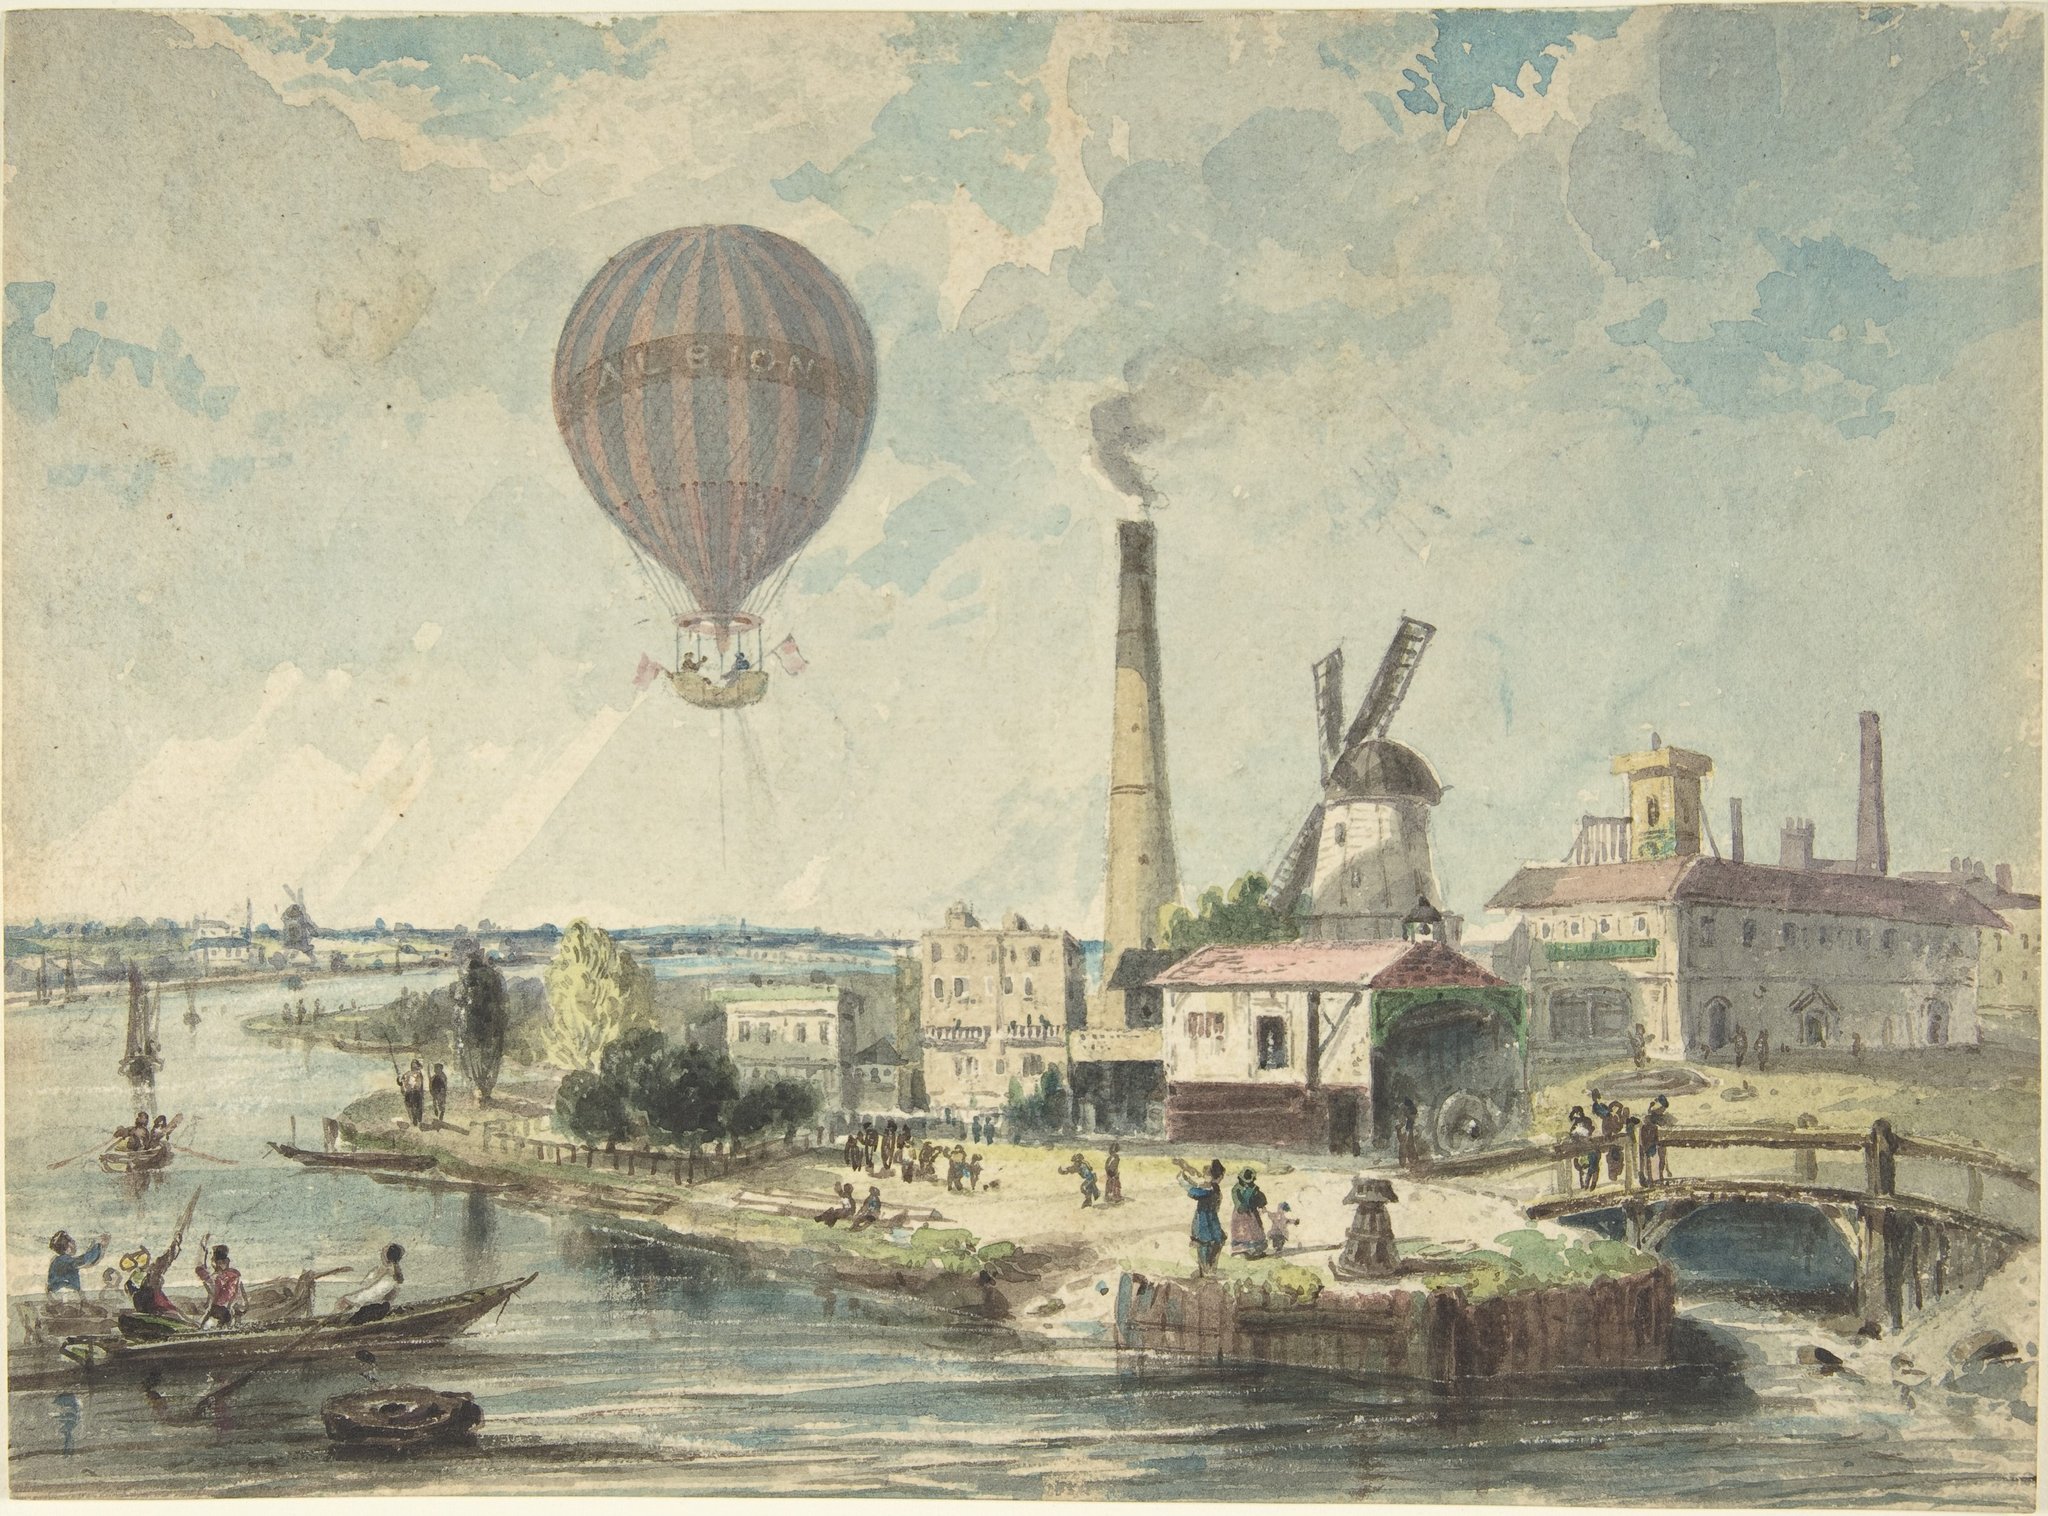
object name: drawing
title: Mr. Green in the Albion Balloon, Having Ascended from Vauxhall Gardens, August 12, 1842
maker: anonymous, british, 19th century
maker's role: artist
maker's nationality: british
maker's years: 1800-1900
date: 1842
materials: watercolor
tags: windmills,hot air balloons